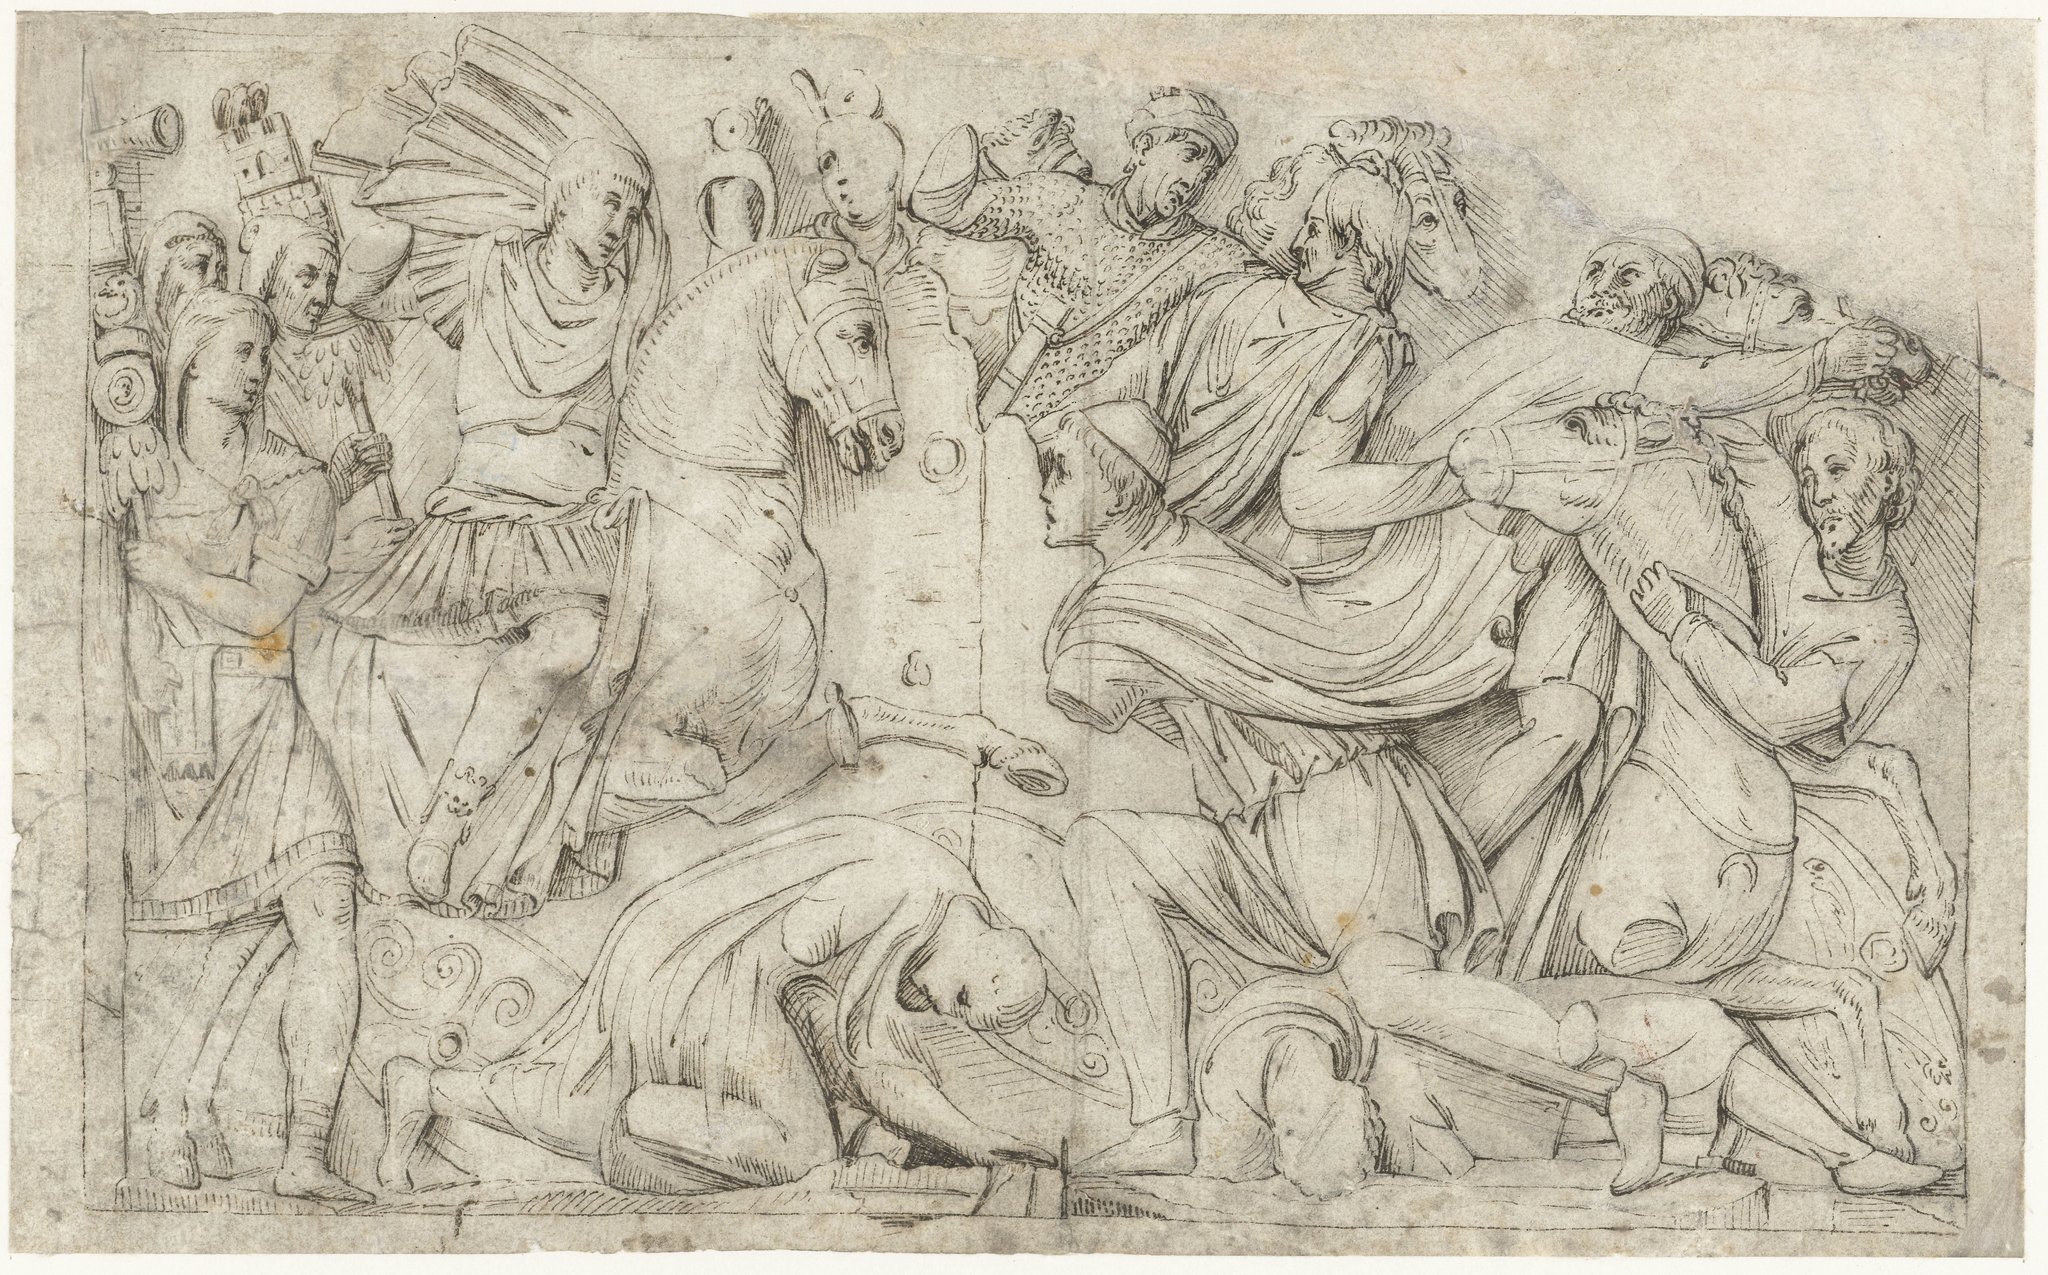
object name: drawing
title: De Boog van Constantijn met Trajanus' overwinning op de Daciërs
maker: gerard ter borch (i)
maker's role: draughtsman, print maker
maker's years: 1584-1662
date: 1609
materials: chalk, ink, paper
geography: rome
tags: arch of constantine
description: Tekening uit het Romeinse schetsboek van de kunstenaar.